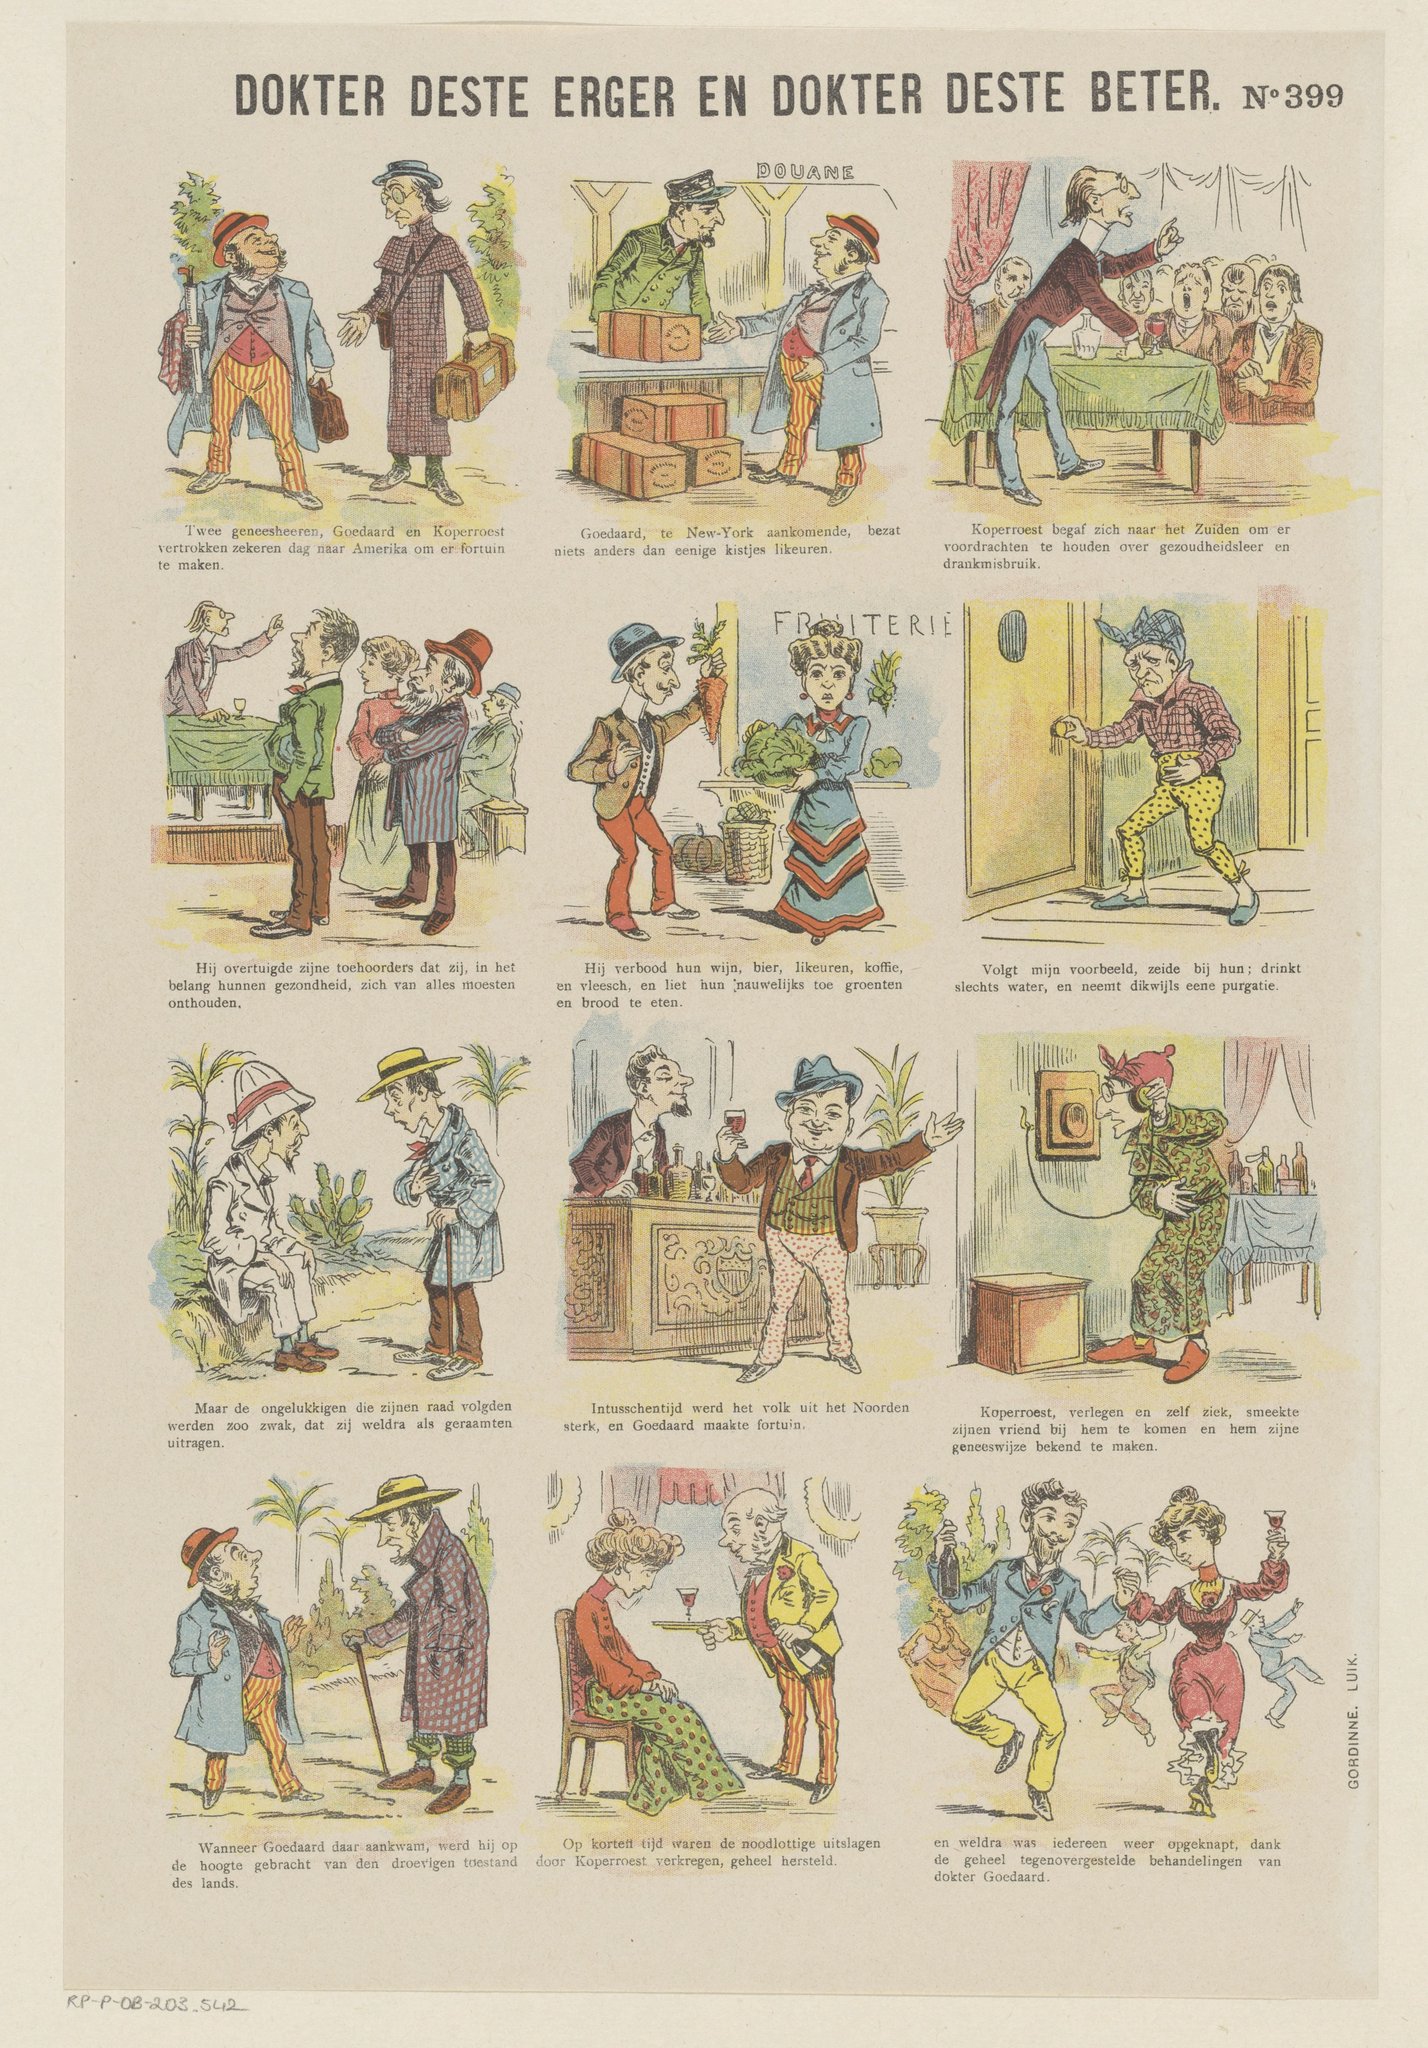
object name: popular print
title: Dokter deste erger en dokter deste beter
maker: Anonymous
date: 1894-1959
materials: paper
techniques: lithograph, letterpress printing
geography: liège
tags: physician, doctor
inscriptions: collector's mark: Lugt 2760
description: Blad met 12 voorstellingen over twee doctoren die naar Amerika vertrekken om daar een fortuin te gaan maken. Onder elke afbeelding een onderschrift. Genummerd rechtsboven: No 399.